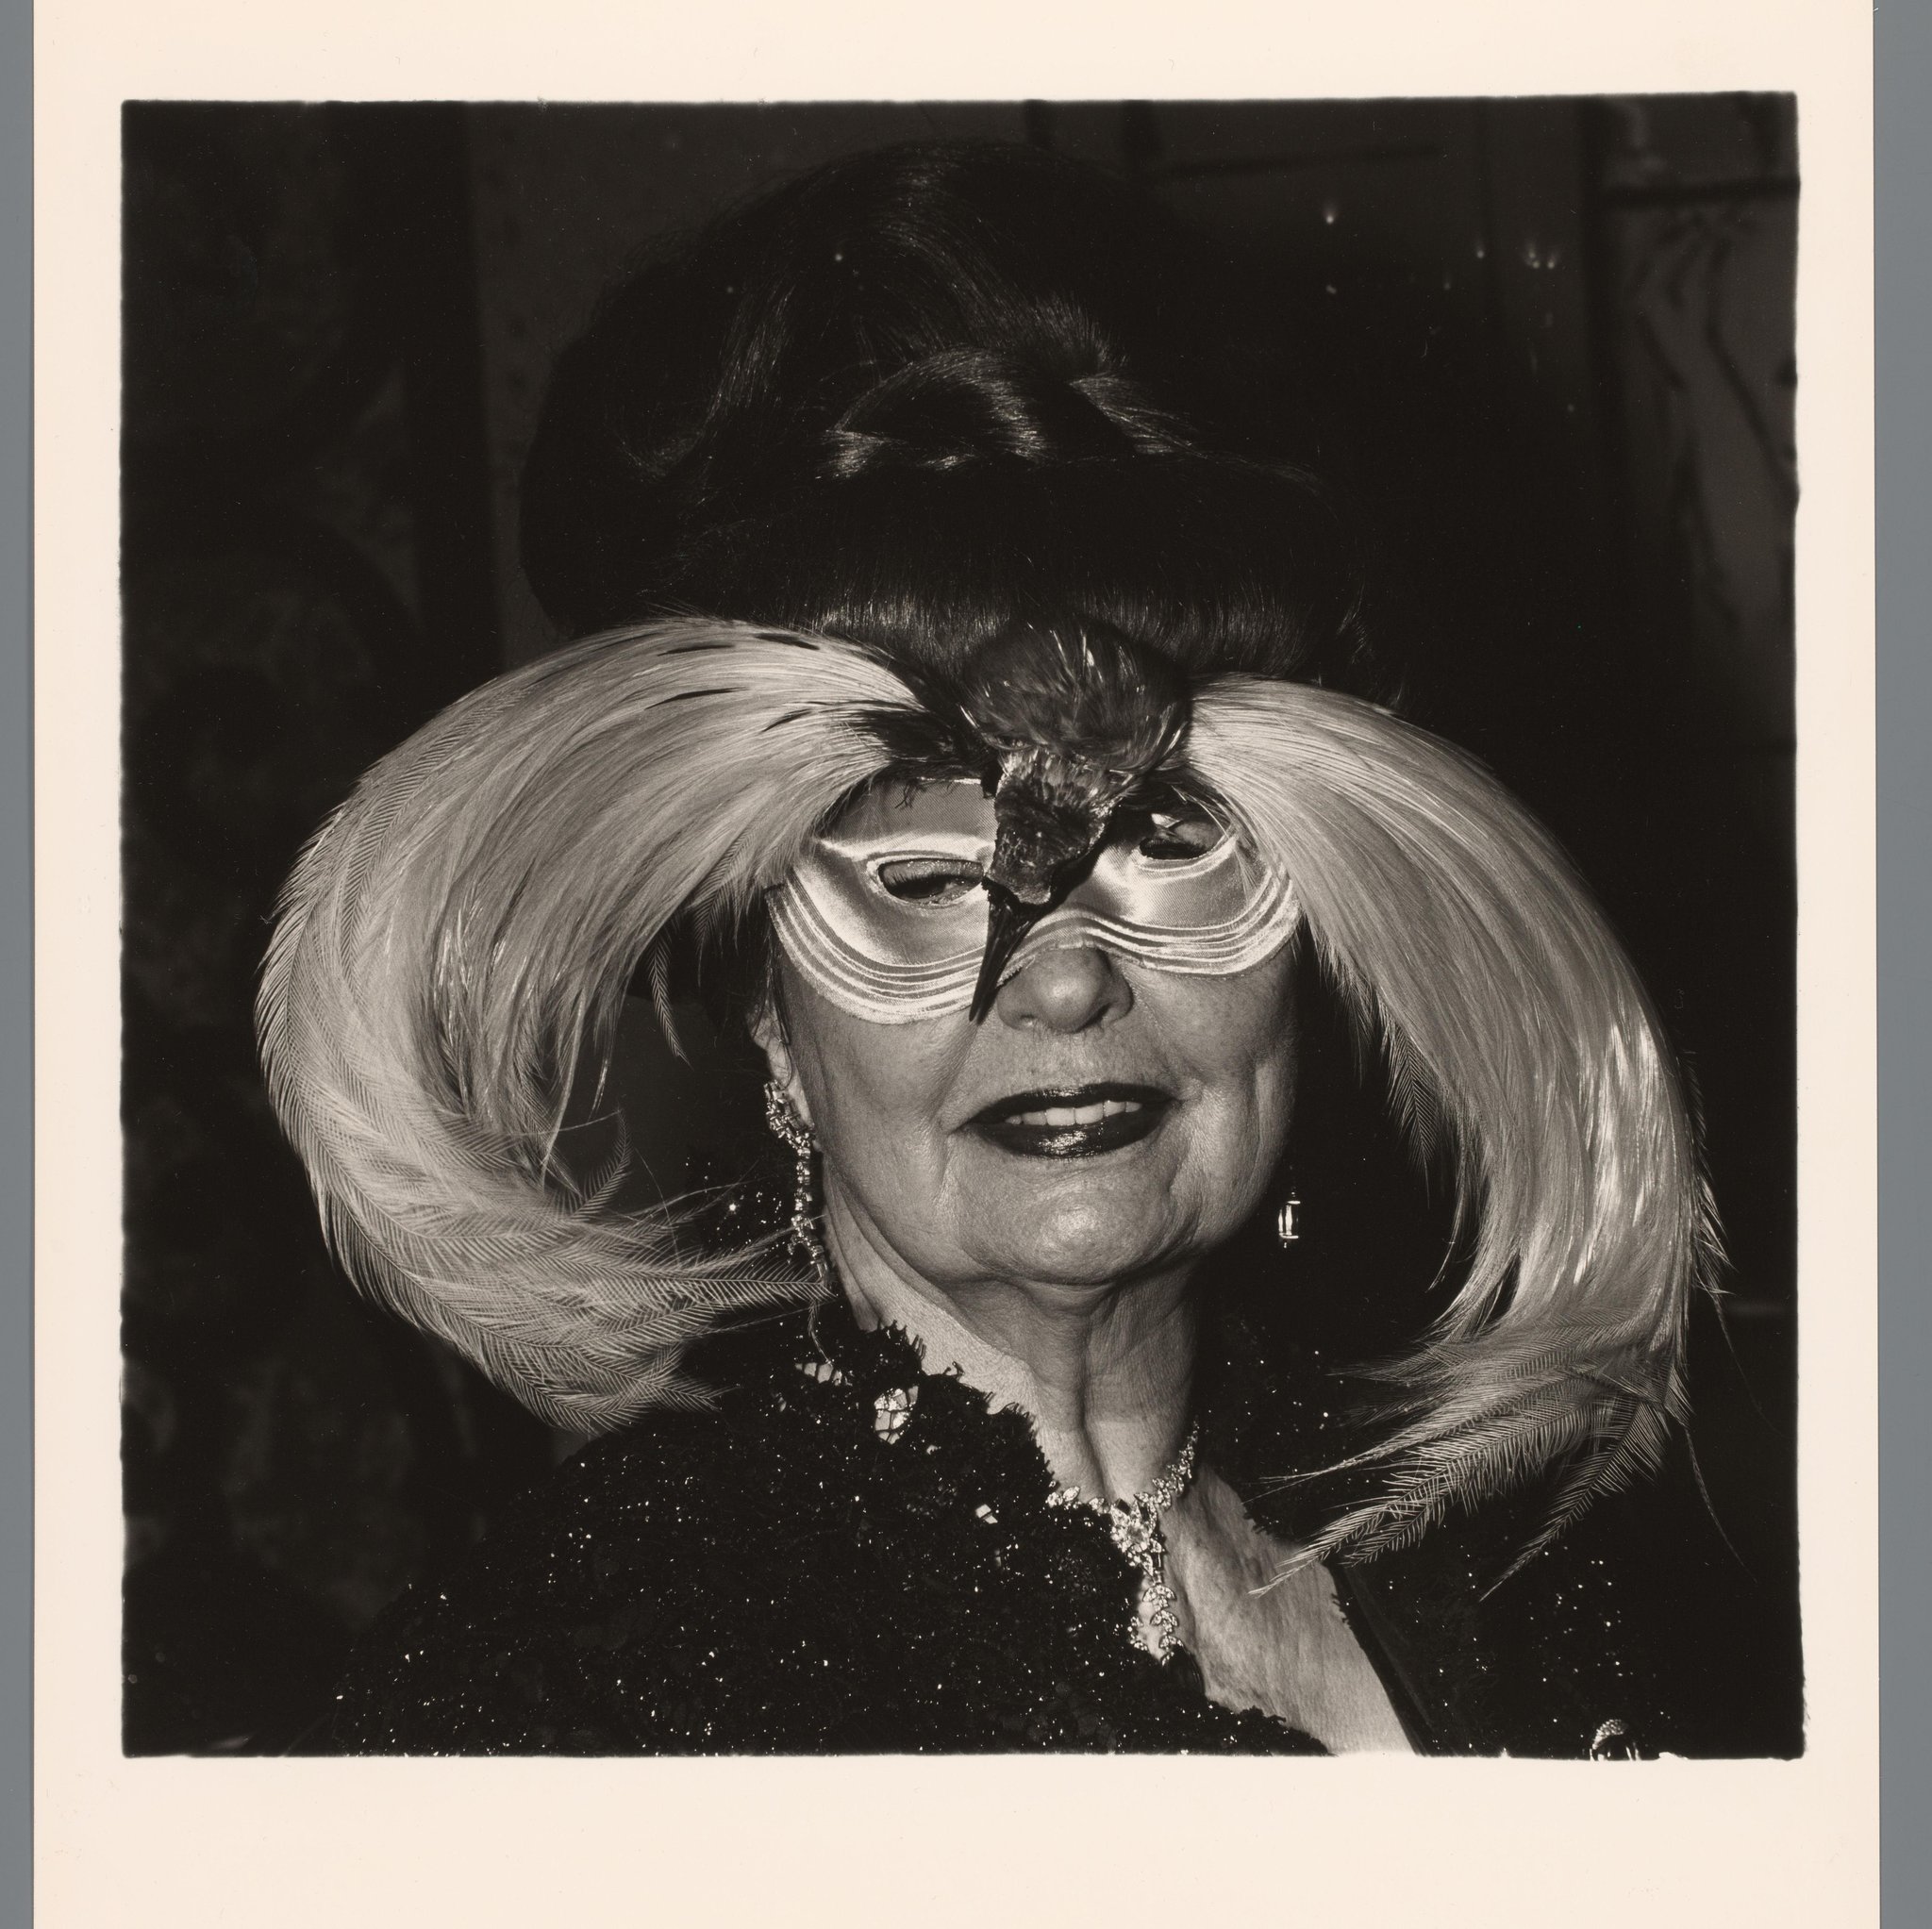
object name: magazine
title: Images secrètes de la guerre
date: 1933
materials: paper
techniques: printing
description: 200 Photographies et documents censurés en France. Recueillis et commentés par Paul Allard en collaboration avec F. Drach, mei 1933.